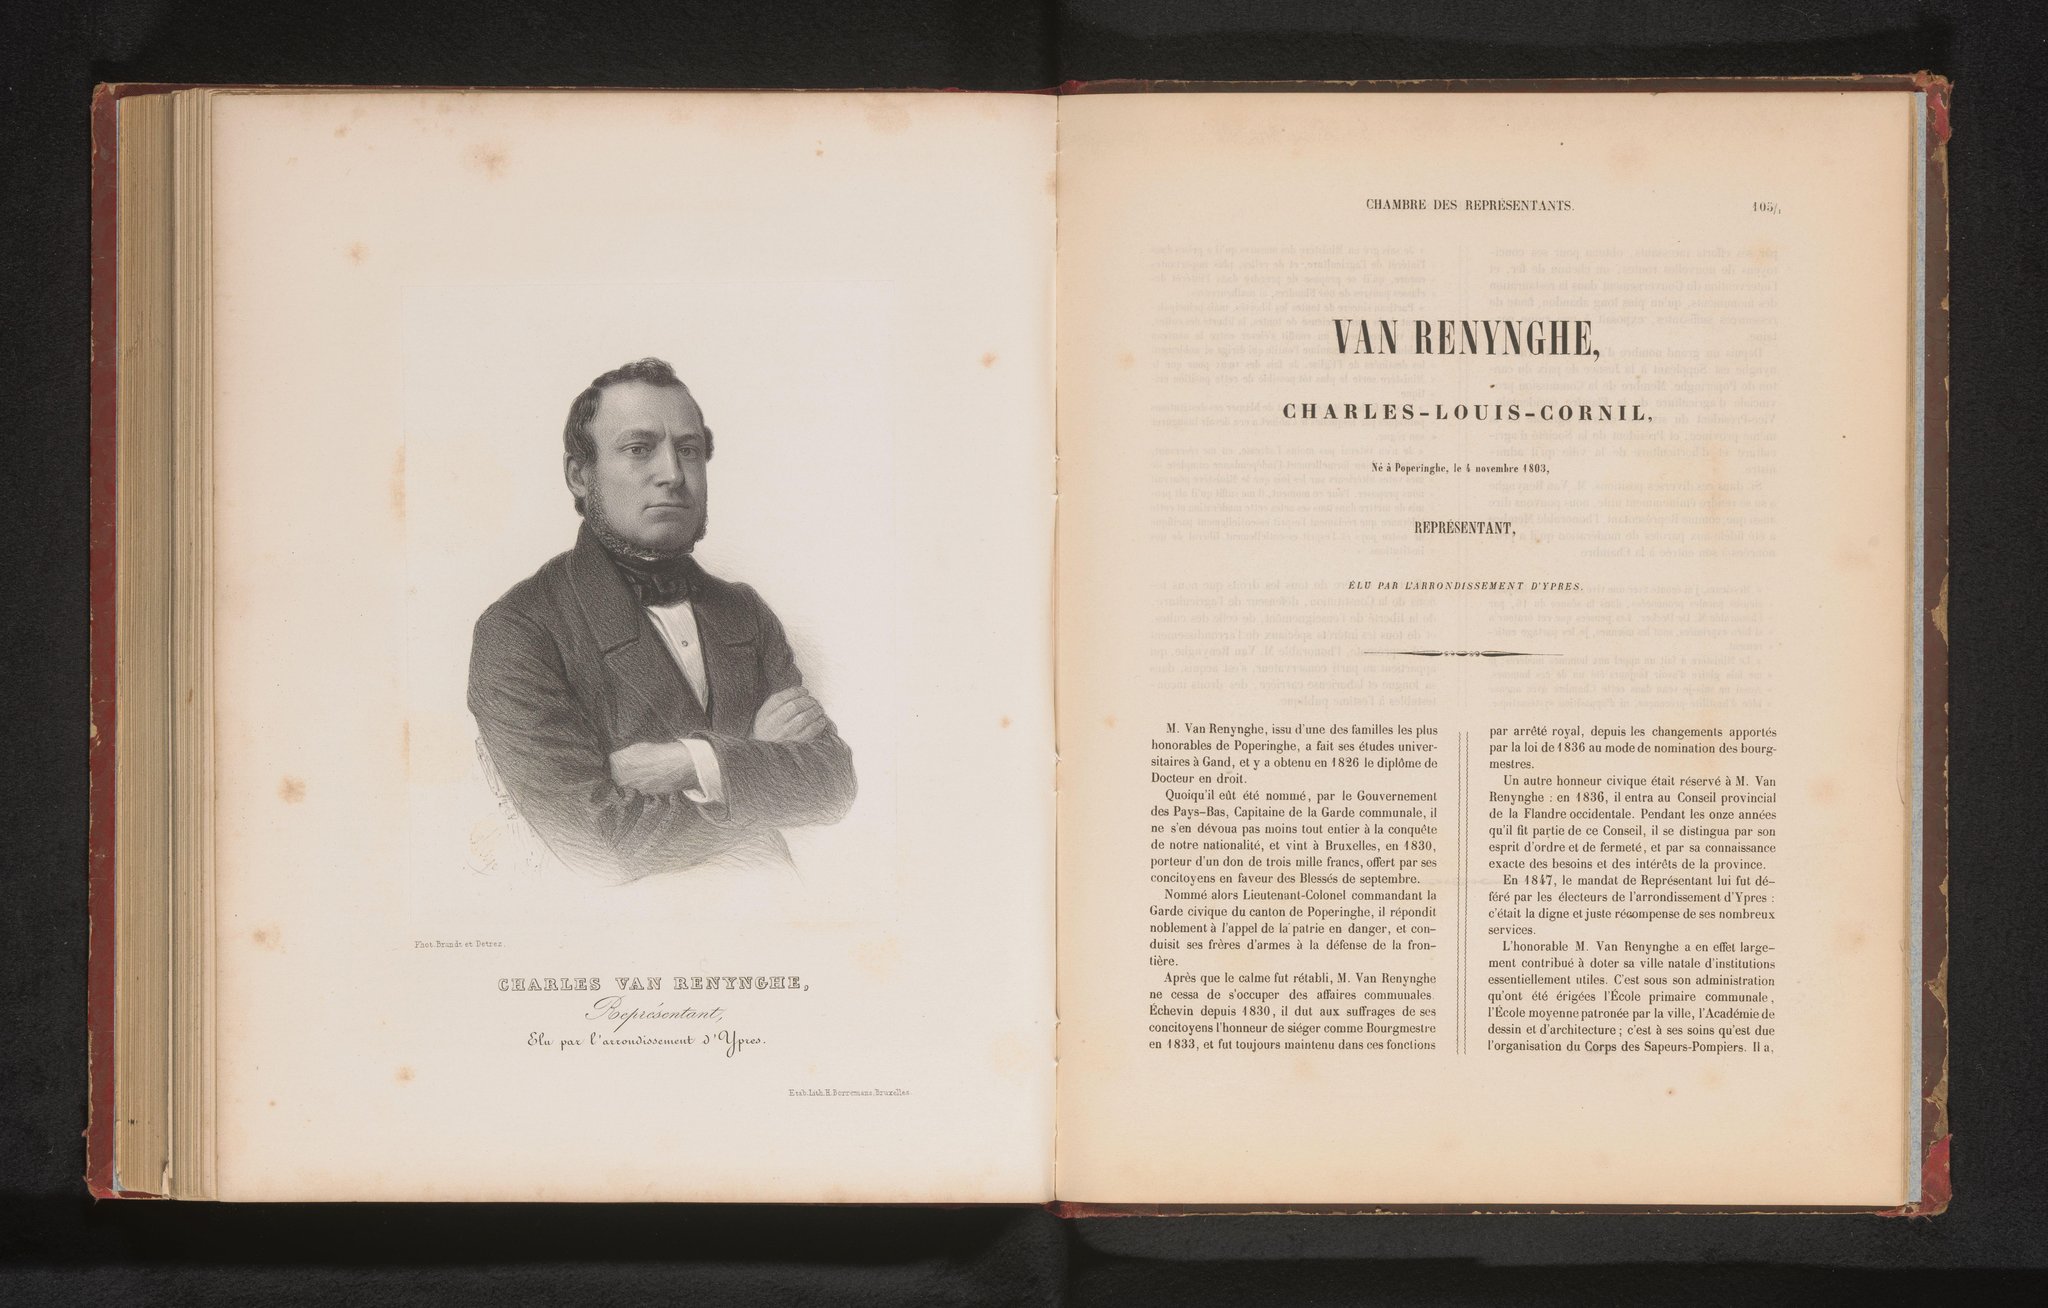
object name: print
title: Reproductie van een foto van een portret van Charles van Renynghe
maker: henri borremans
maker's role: print maker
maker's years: 1800-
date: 1853-1858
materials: paper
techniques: lithograph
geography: brussels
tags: politician, historical persons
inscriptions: inscription: ‘Représentant,/ Elu par l'arrondissement de Ypres.’